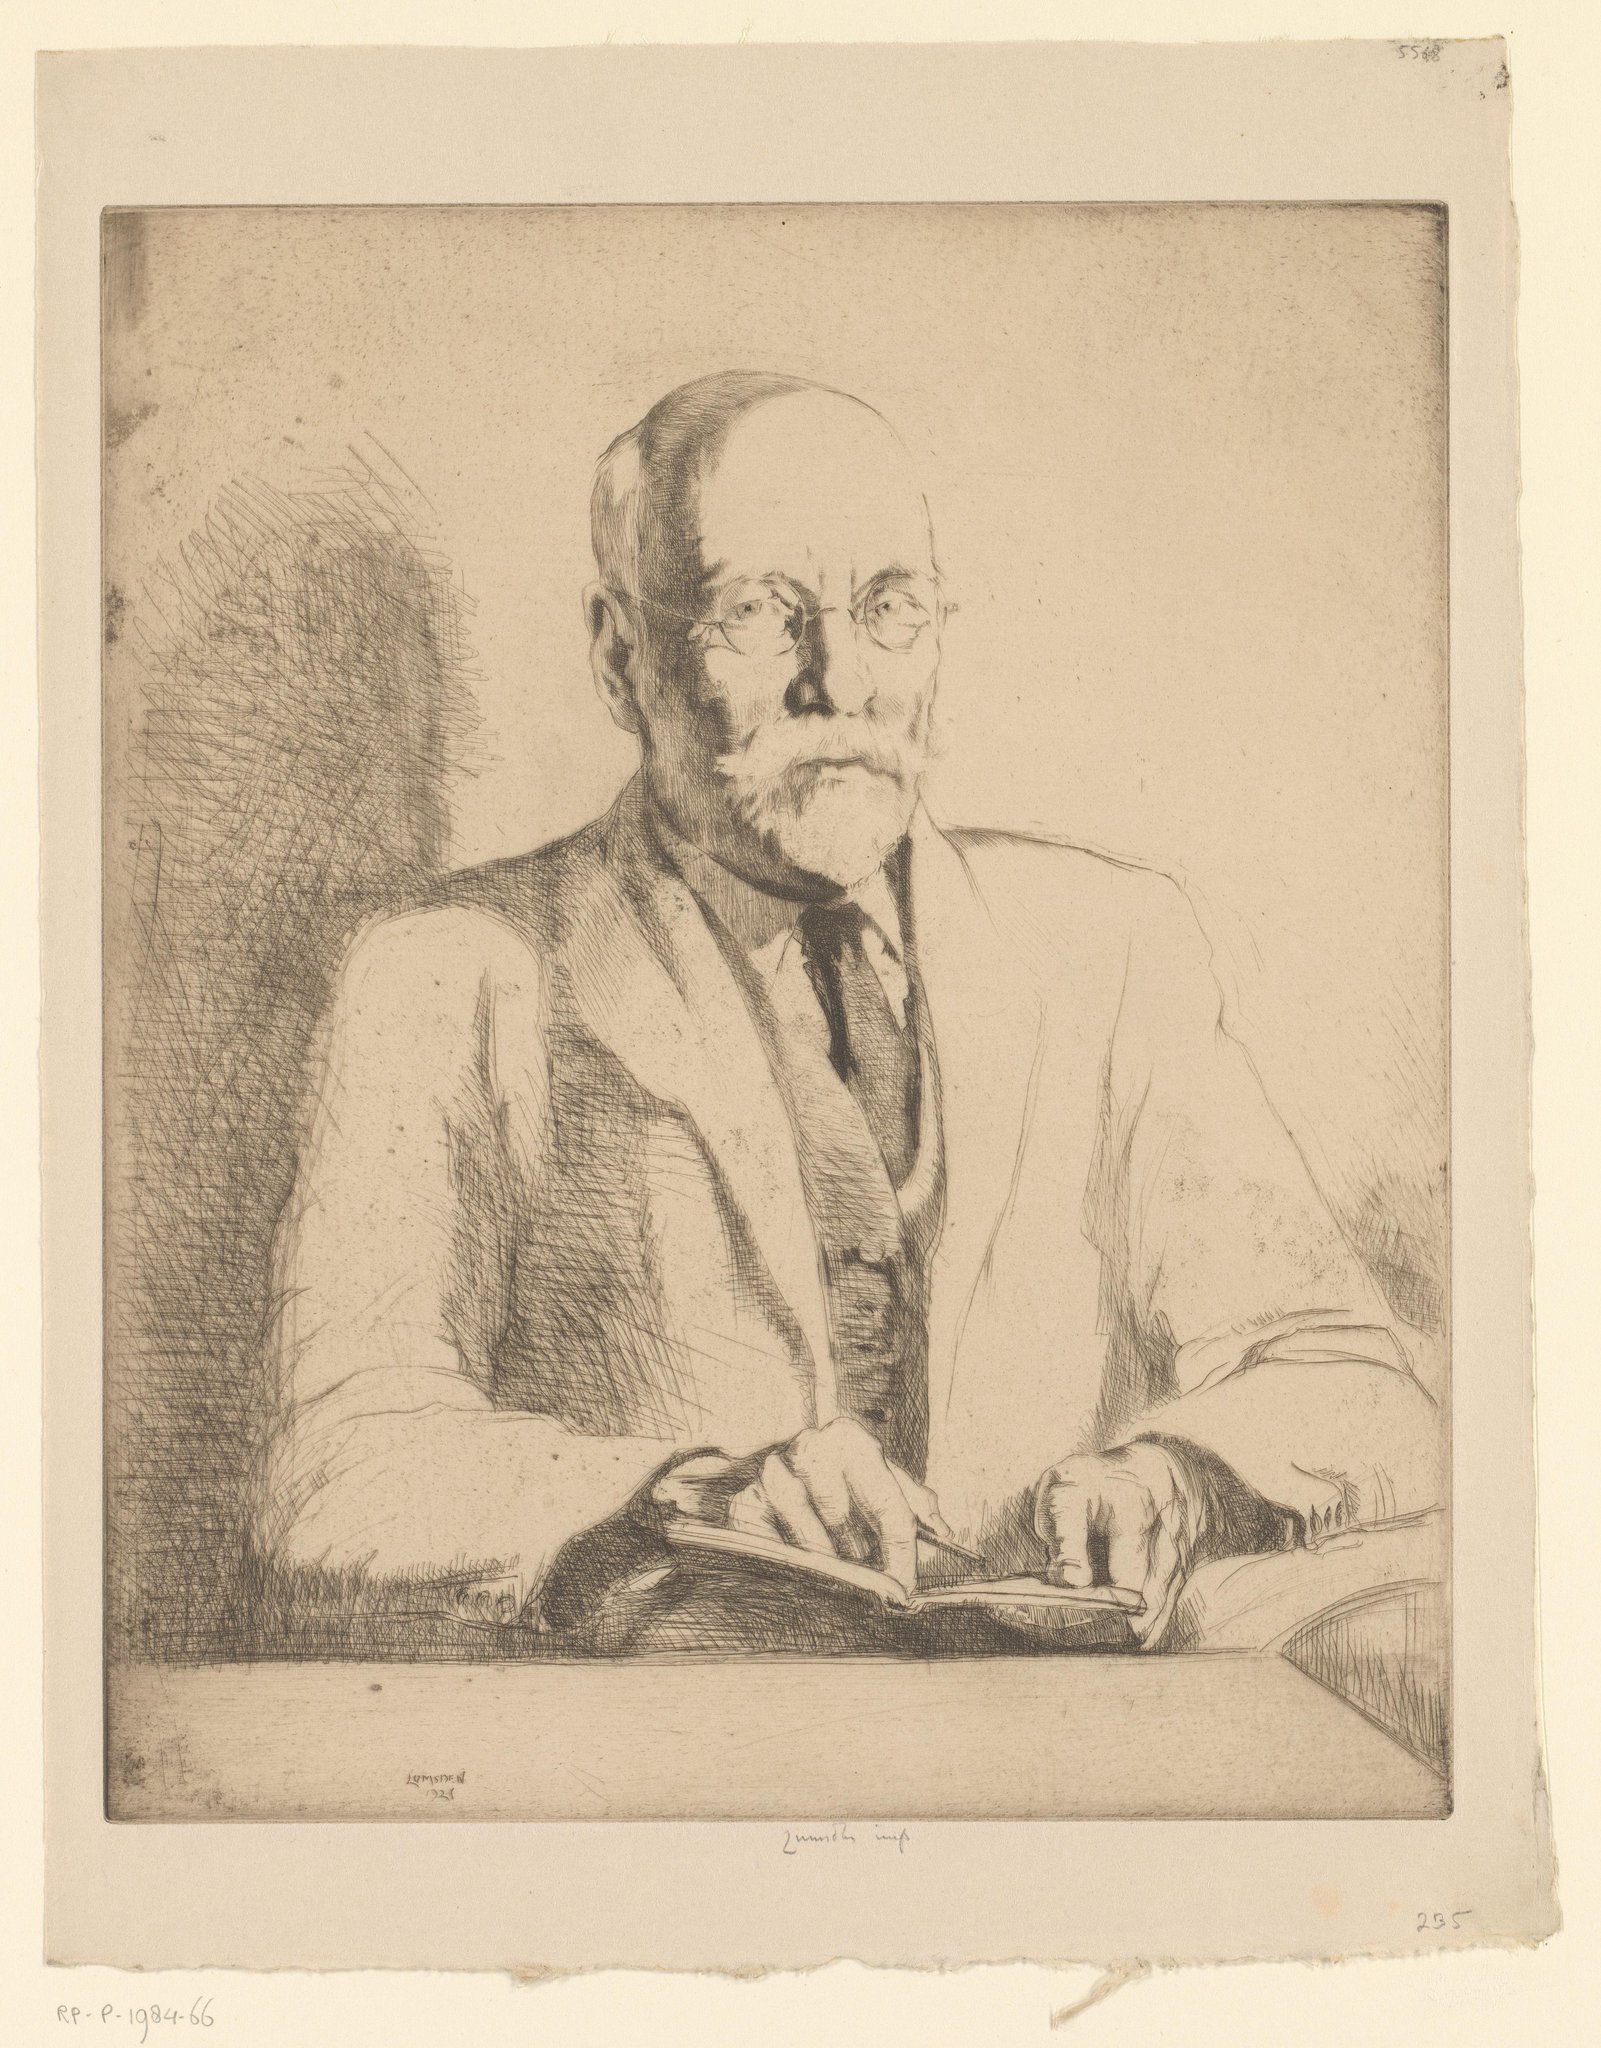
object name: print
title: Portret van George Clausen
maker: ernest stephen lumsden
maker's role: print maker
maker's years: 1883-1948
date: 1921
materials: paper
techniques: etching, intaglio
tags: draughtsman, george clausen, portrait, self-portrait of artist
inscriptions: collector's mark: Lugt 2228, collector's mark: Lugt 2760